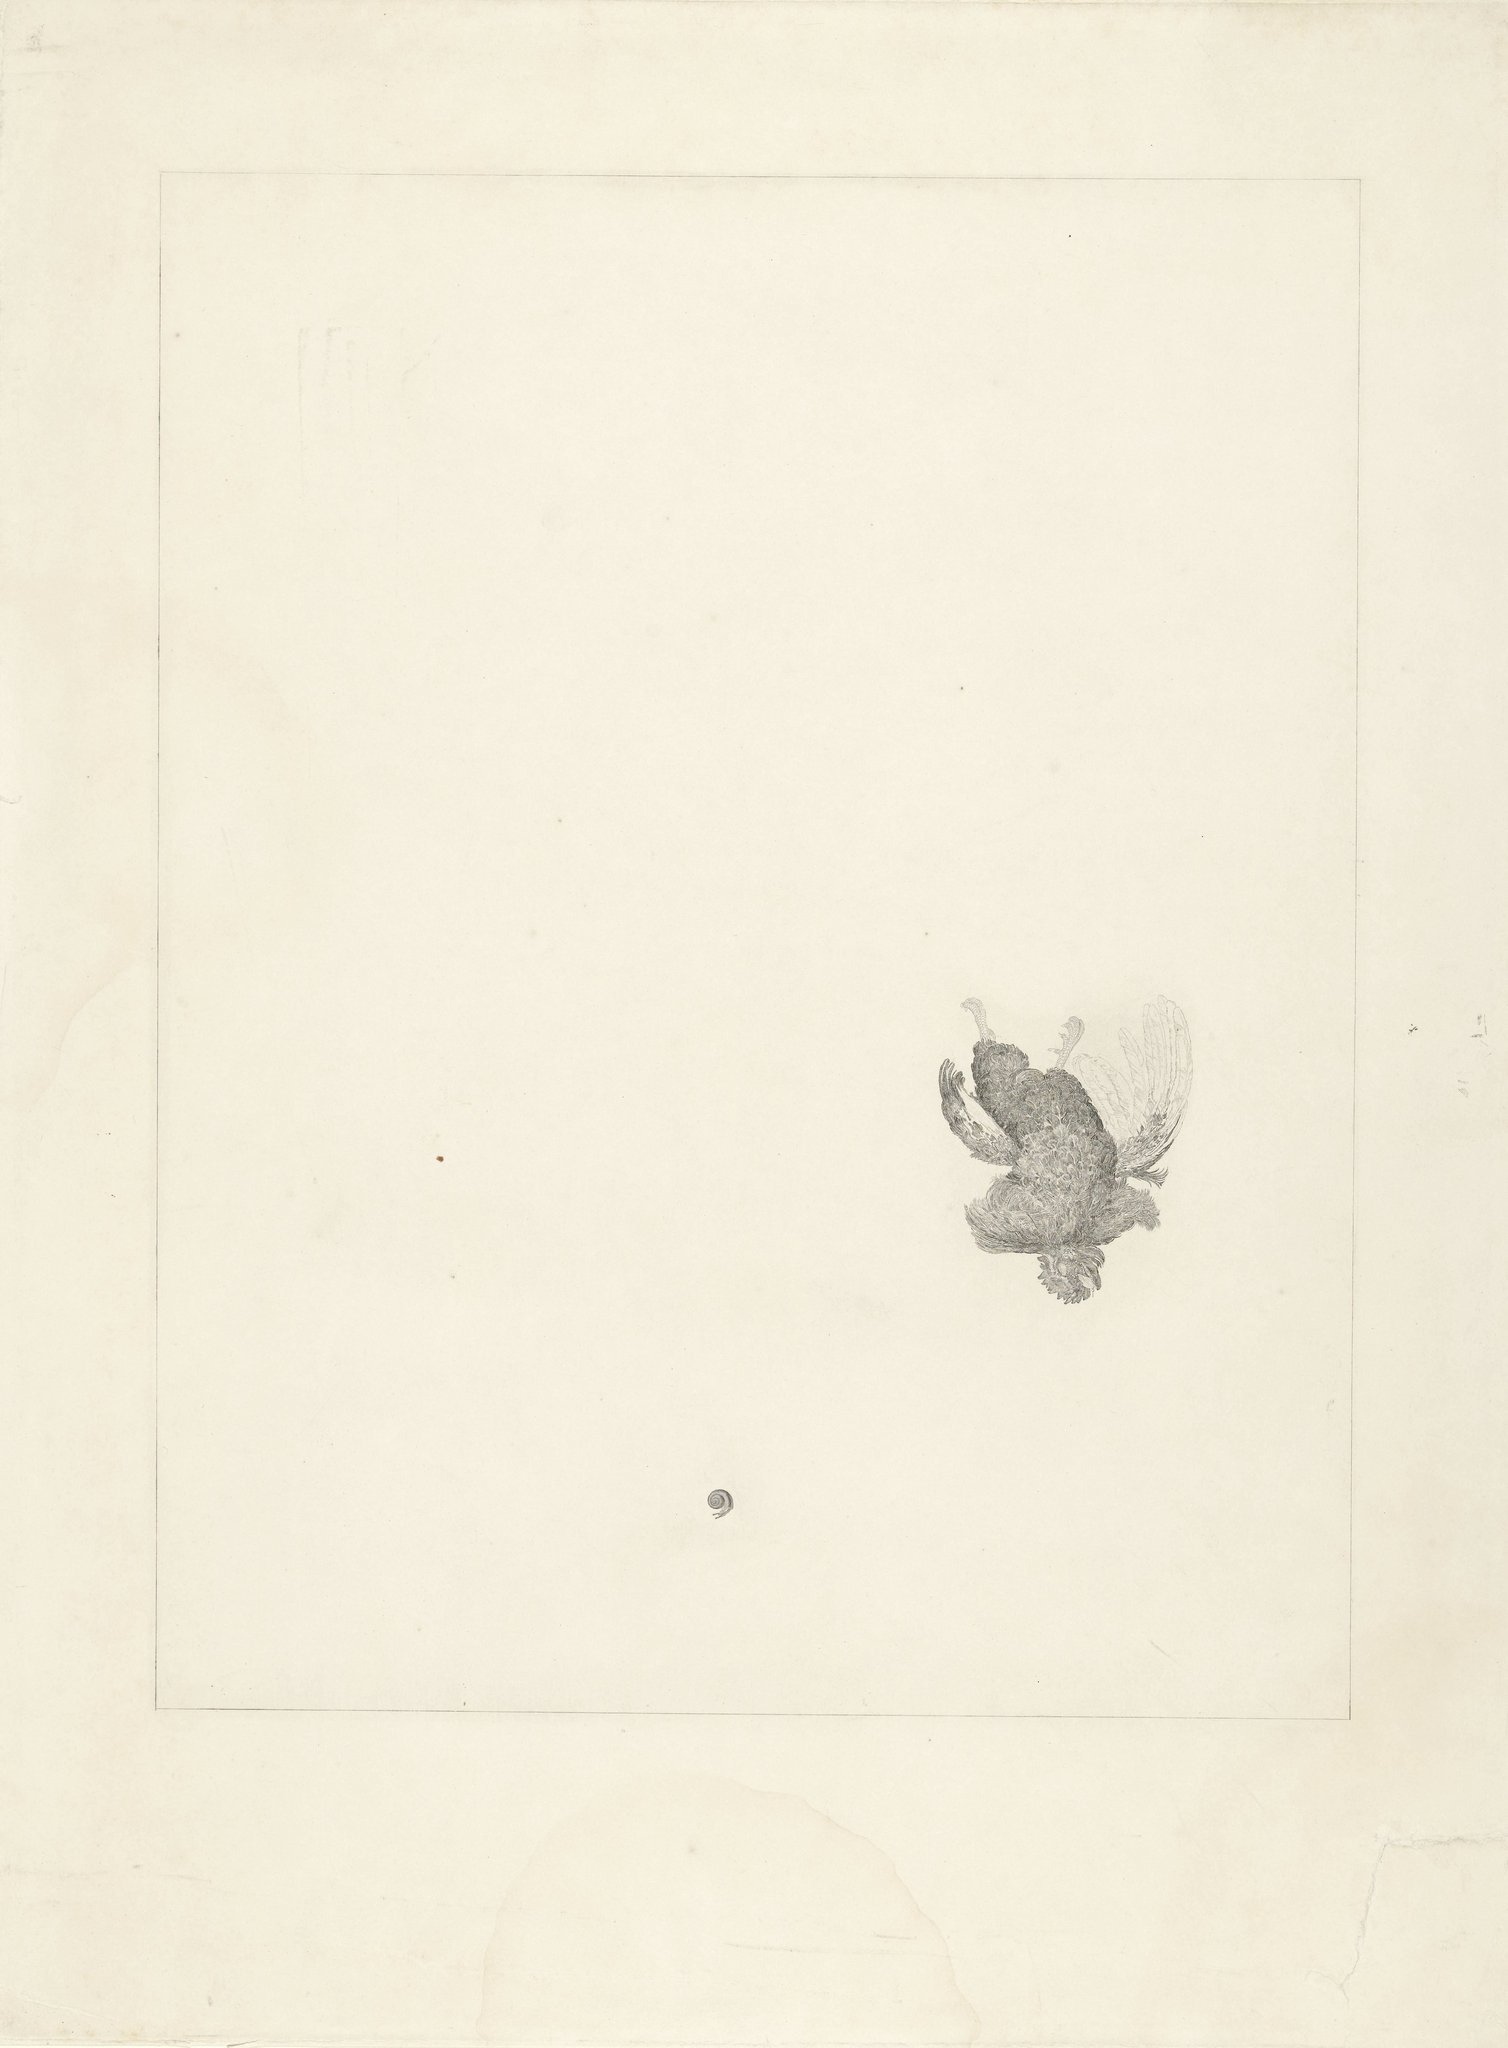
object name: print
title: Vrouw met mand met vruchten in de hand bij het raam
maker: henricus wilhelmus couwenberg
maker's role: draughtsman, print maker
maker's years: 1814-1845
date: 1840-1842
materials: paper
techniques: etching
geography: amsterdam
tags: human figure at (open) window, seen from outside, shop-window, show-window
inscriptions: collector's mark: Lugt 2228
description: Staat 1 tot 15 door Henricus Wilhelmus Couwenberg, staat 15 tot 24 door Johannes de Mare en staat 24 en 25 door Johann Wilhelm Kaiser.